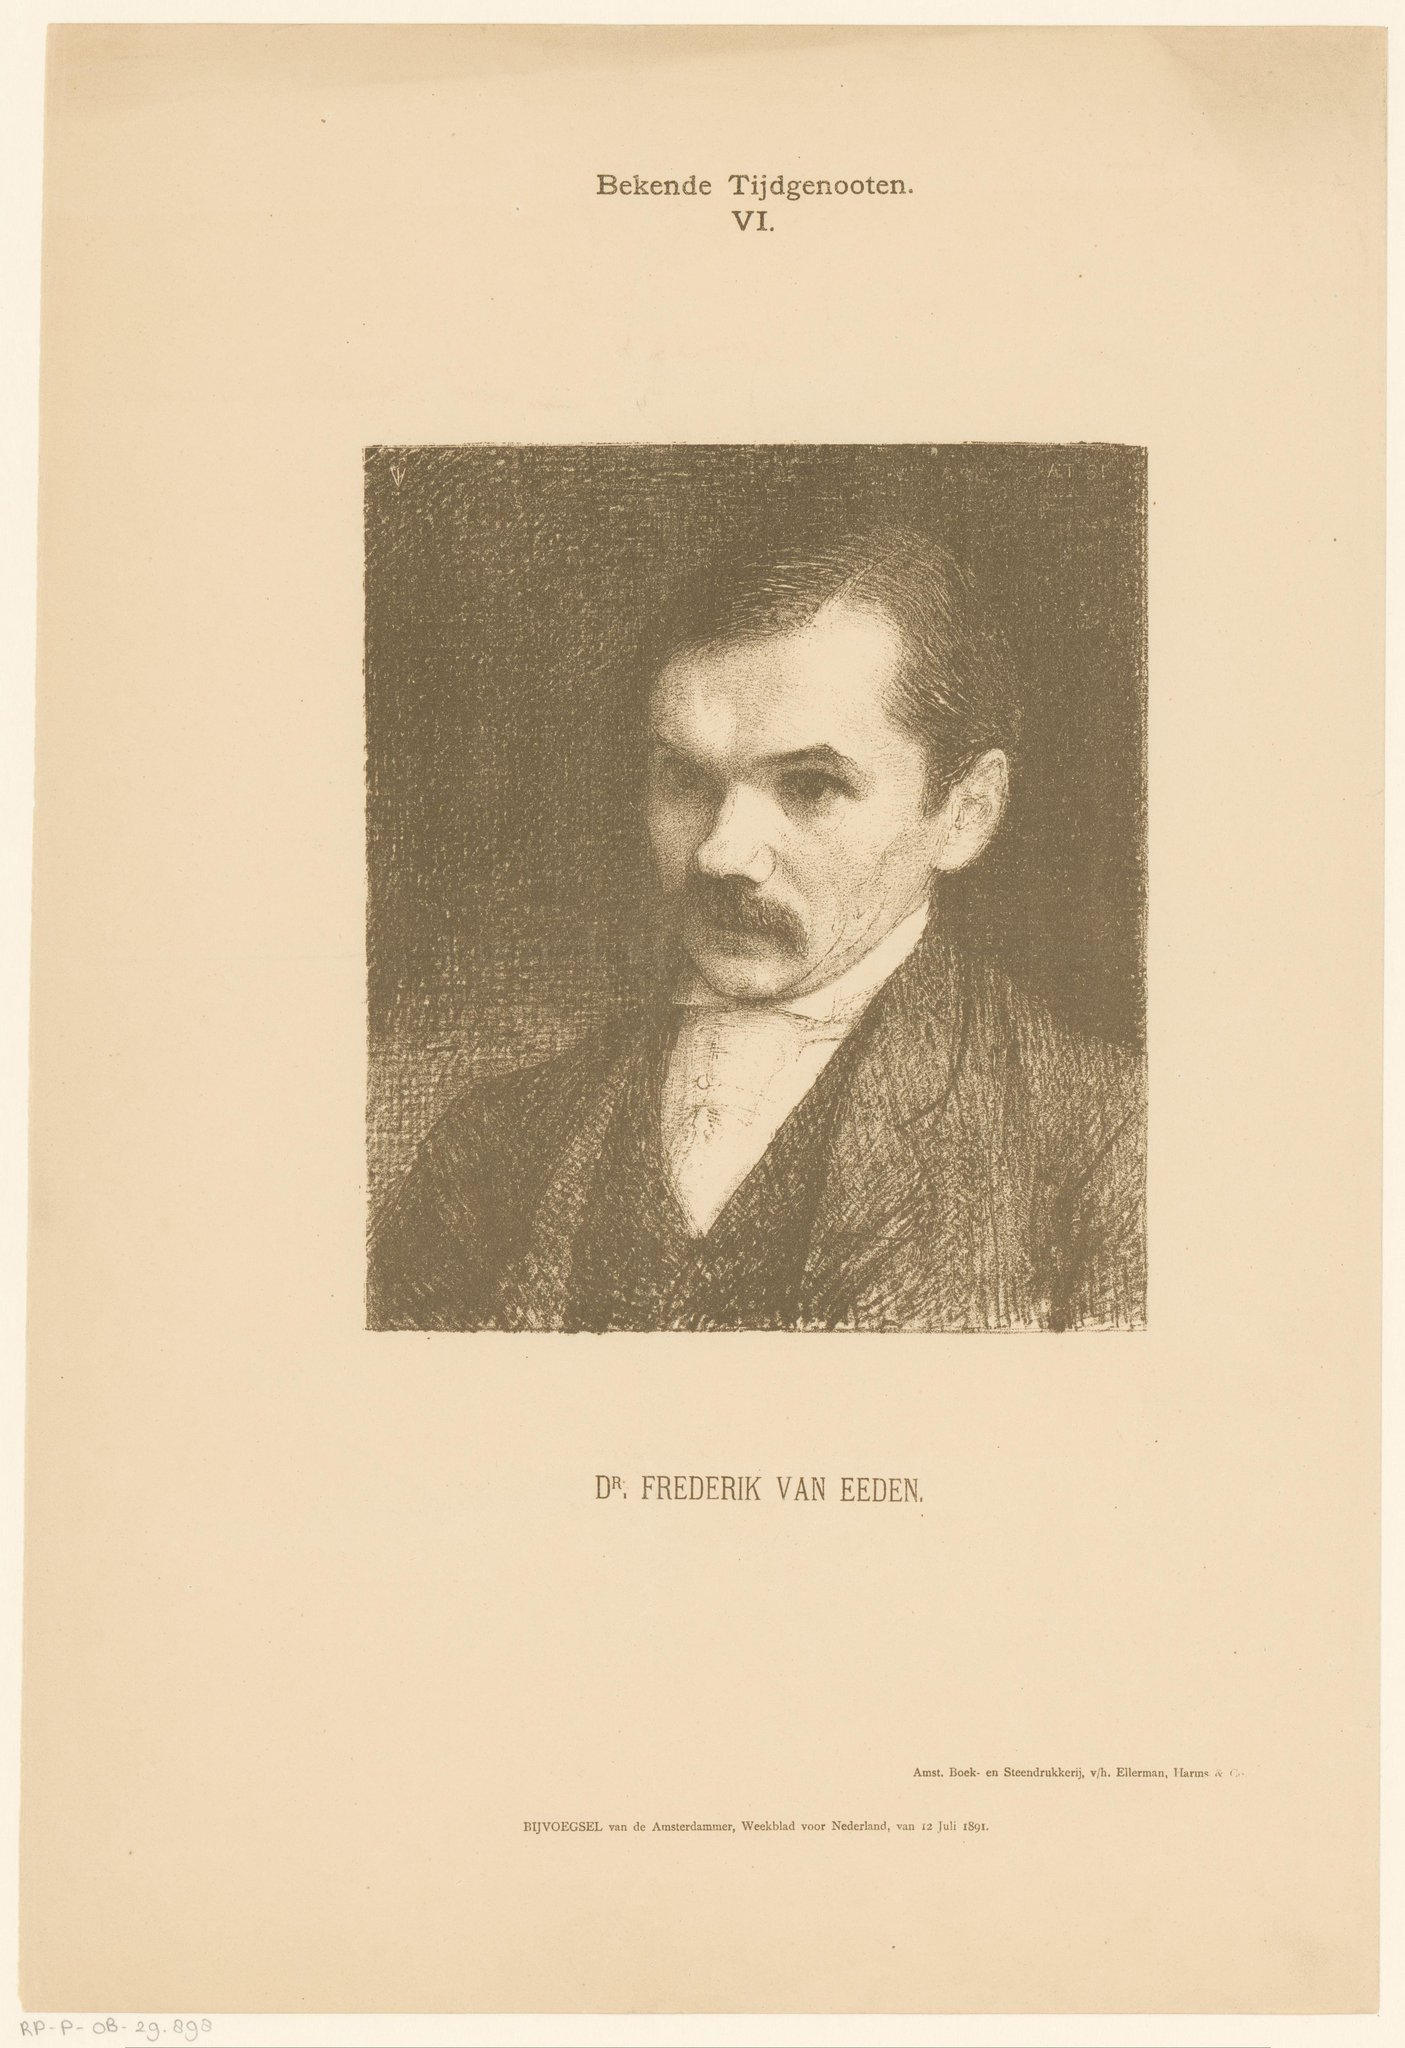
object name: print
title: Portret van Frederik van Eeden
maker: jan veth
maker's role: designer, draughtsman, painter, print maker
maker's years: 1864-1925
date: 1891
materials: paper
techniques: lithograph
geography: amsterdam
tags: frederik van eeden, historical persons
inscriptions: collector's mark: Lugt 2228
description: Deze prent werd uitgegeven als bijvoegsel van De Amsterdammer op 12 juli 1891.